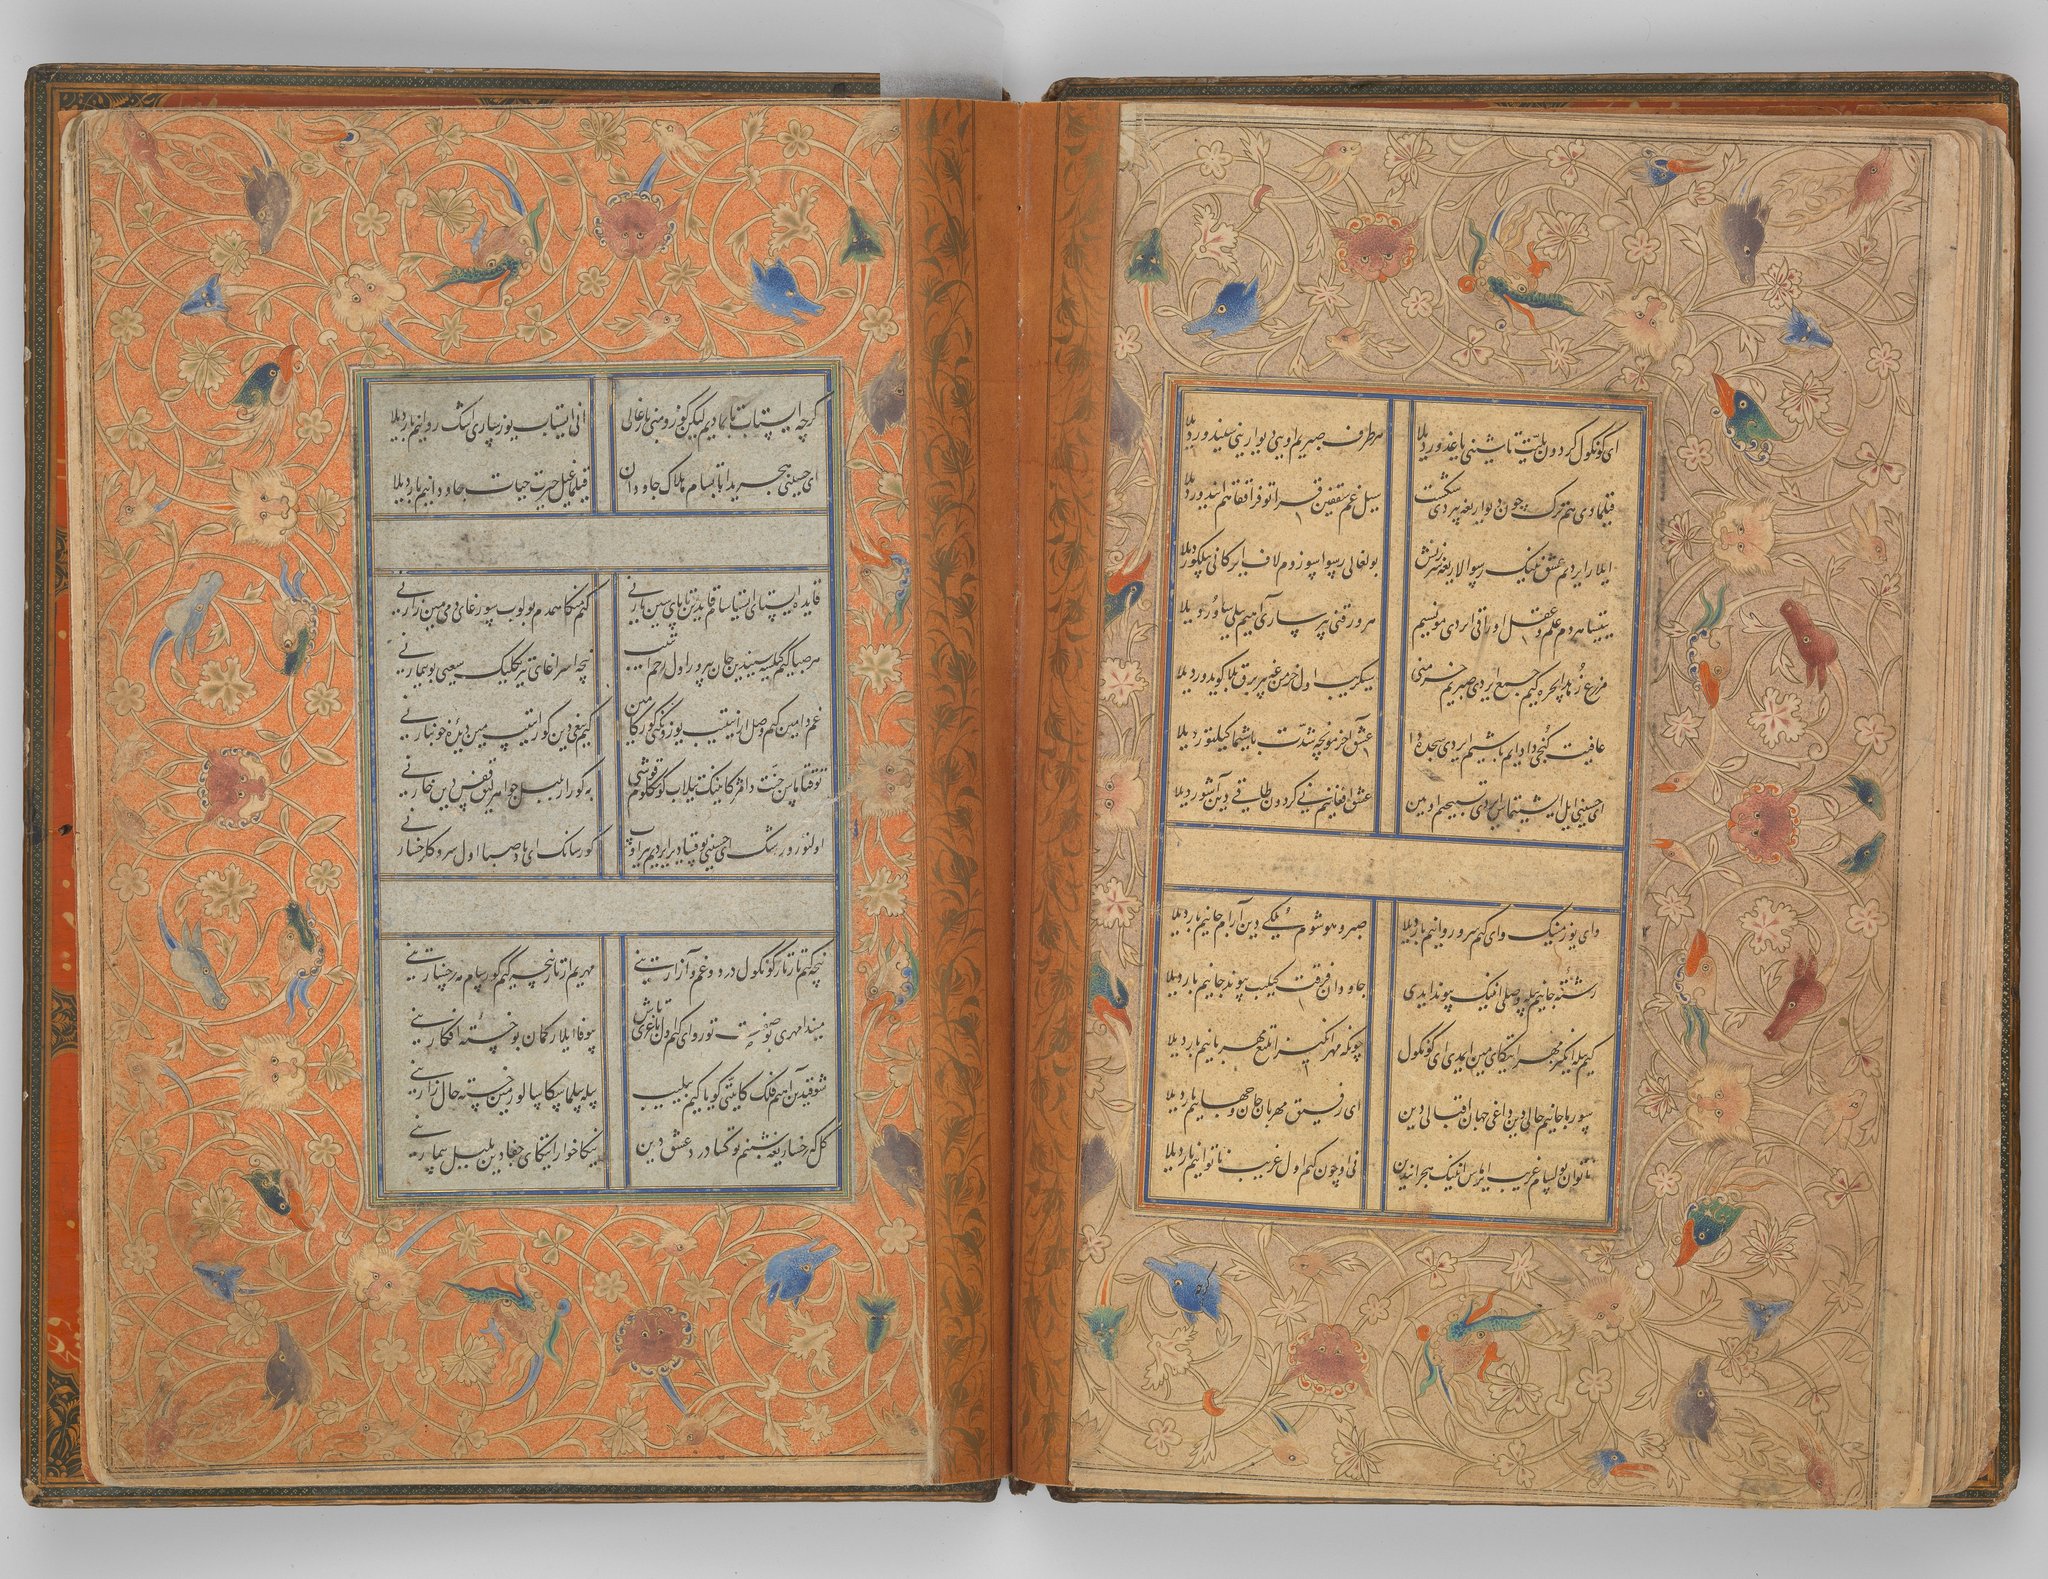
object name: non illustrated manuscript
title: Divan of Sultan Husayn Baiqara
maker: sultan 'ali al-mashhadi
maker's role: calligrapher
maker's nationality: iranian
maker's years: 1453-1520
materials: gold, ink, lacquer, paper, watercolor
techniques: bookbinding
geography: afghanistan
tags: animals